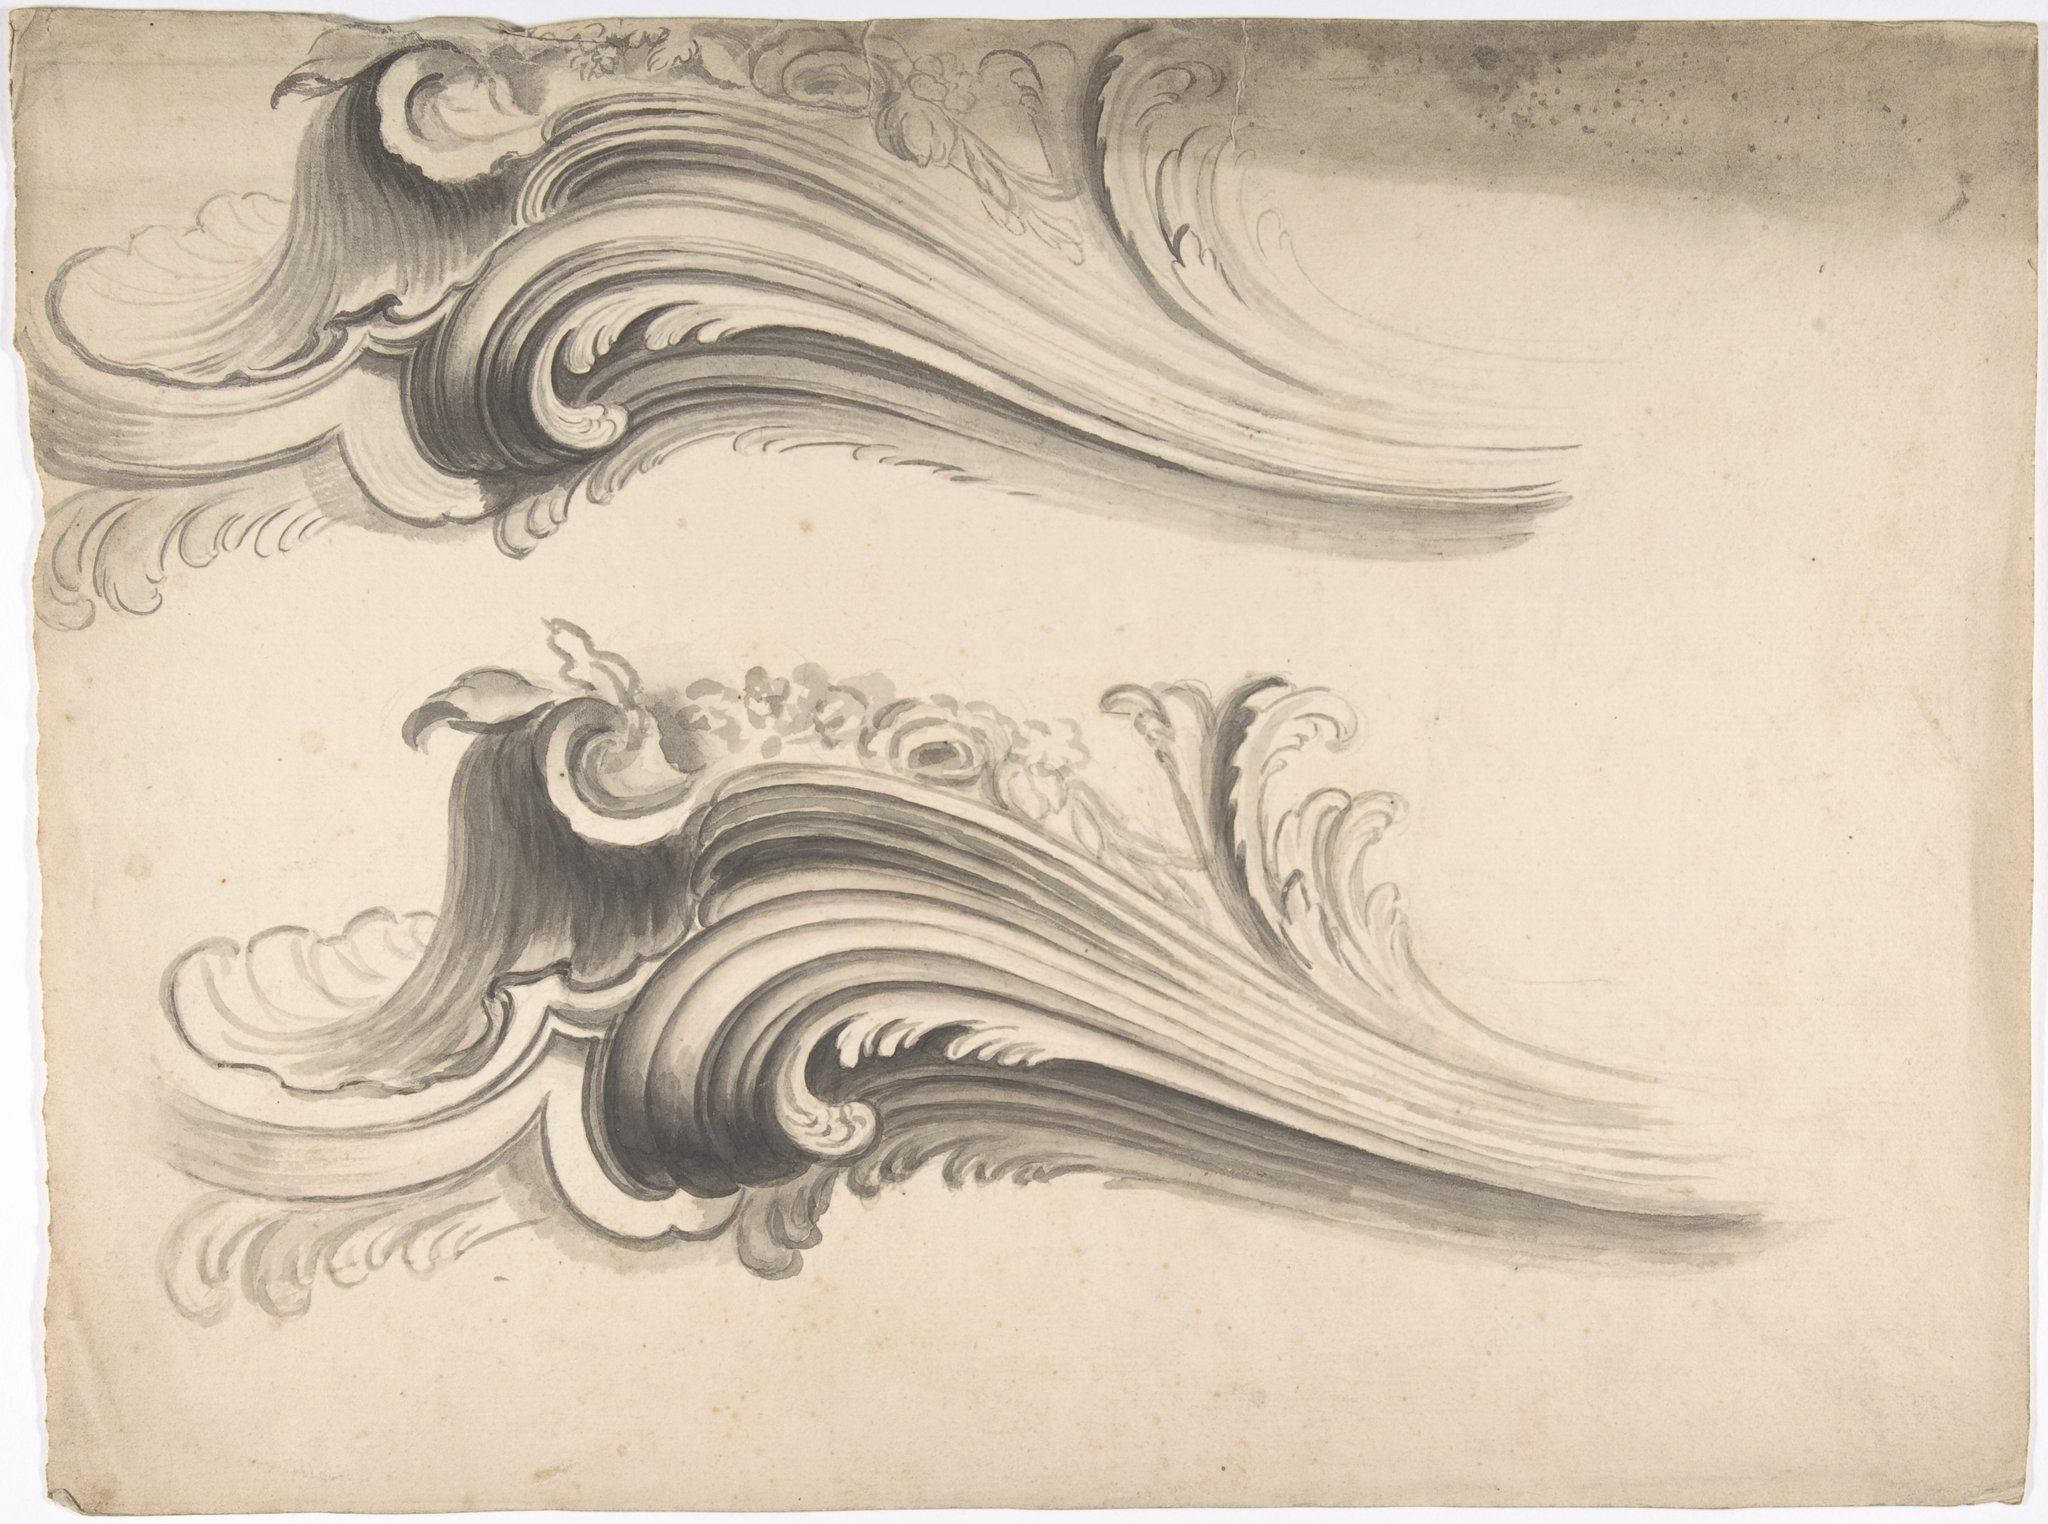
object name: drawing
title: Designs for Foliate Ornament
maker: anonymous, british, 19th century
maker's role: artist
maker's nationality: british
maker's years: 1800-1900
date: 1801-1900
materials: ink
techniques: brush, pen, wash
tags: ornament